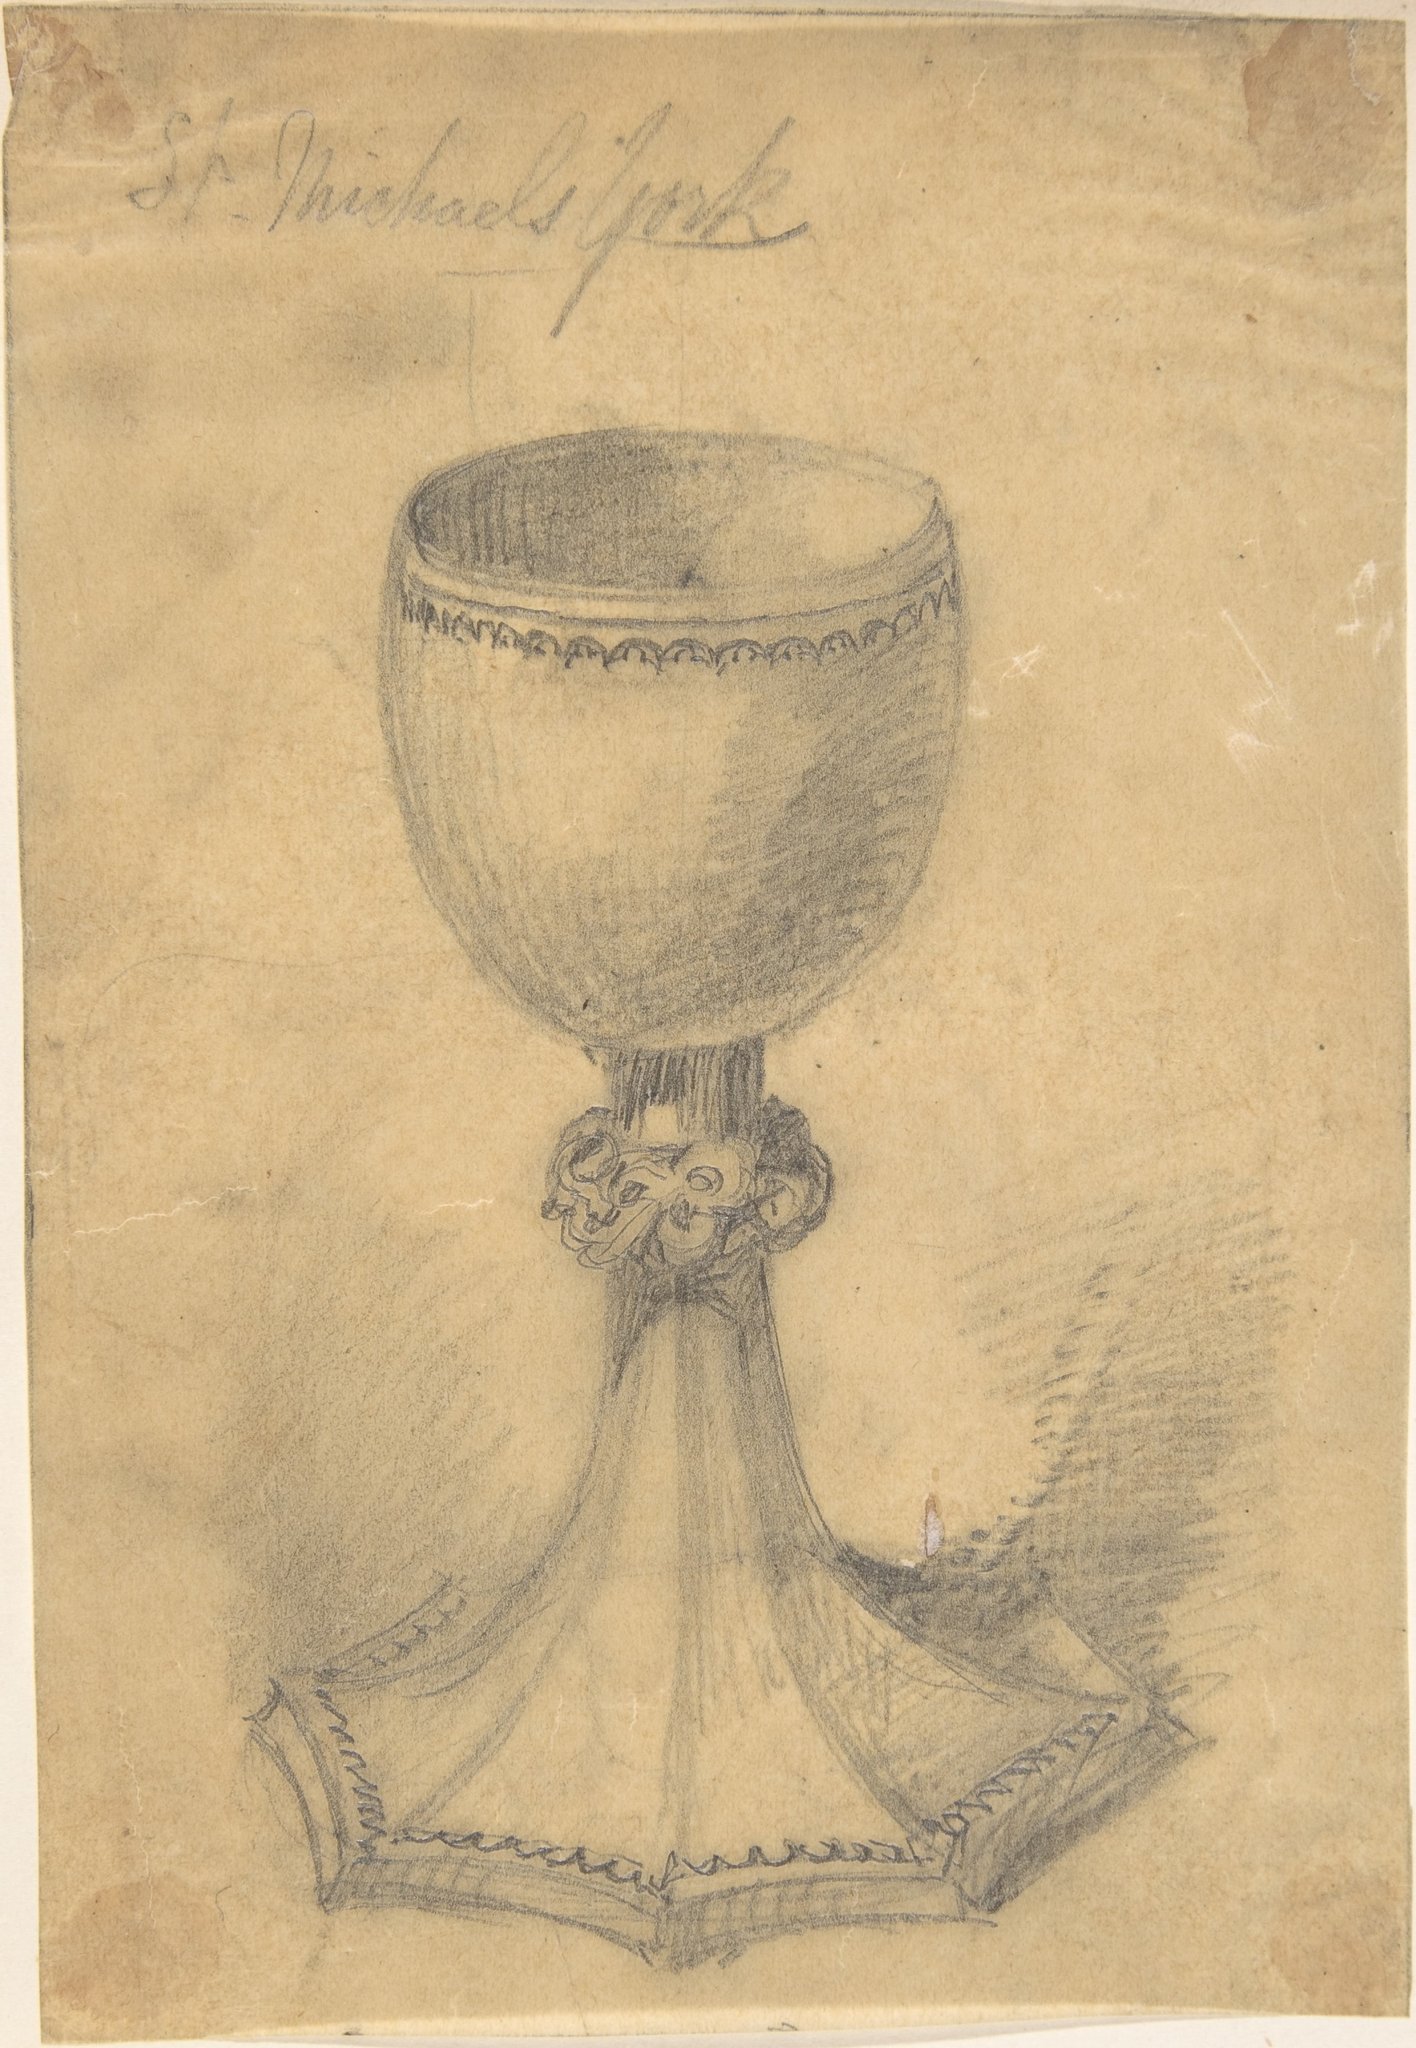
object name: drawing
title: Chalice from St. Michael's York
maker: anonymous, british, 19th century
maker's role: artist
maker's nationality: british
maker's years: 1800-1900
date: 1851-1900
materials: graphite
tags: chalices